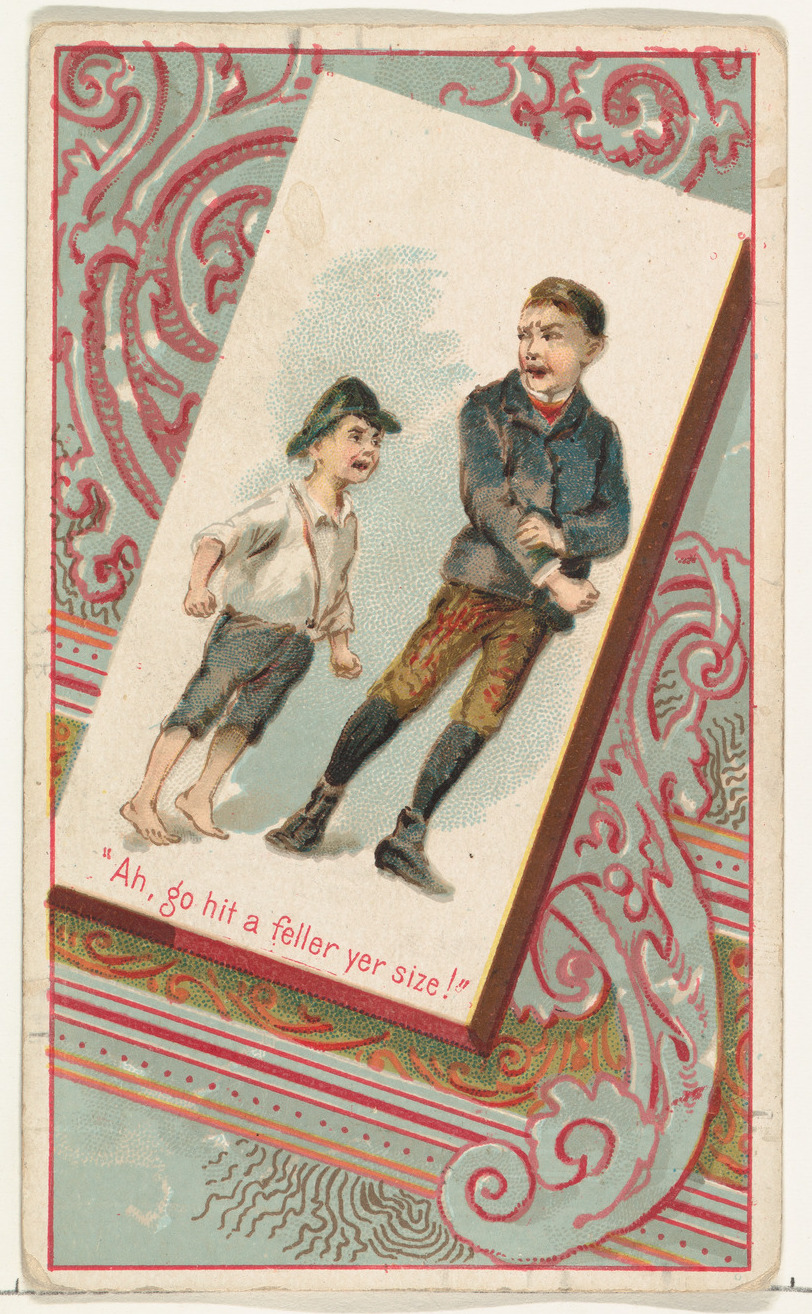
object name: print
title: "Ah, go hit a feller yer size!," from the Terrors of America set (N136) issued by Duke Sons & Co. to promote Honest Long Cut Tobacco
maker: w. duke, sons & co.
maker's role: publisher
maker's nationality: american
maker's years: 1870-1920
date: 1888-1889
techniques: color lithograph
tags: boys